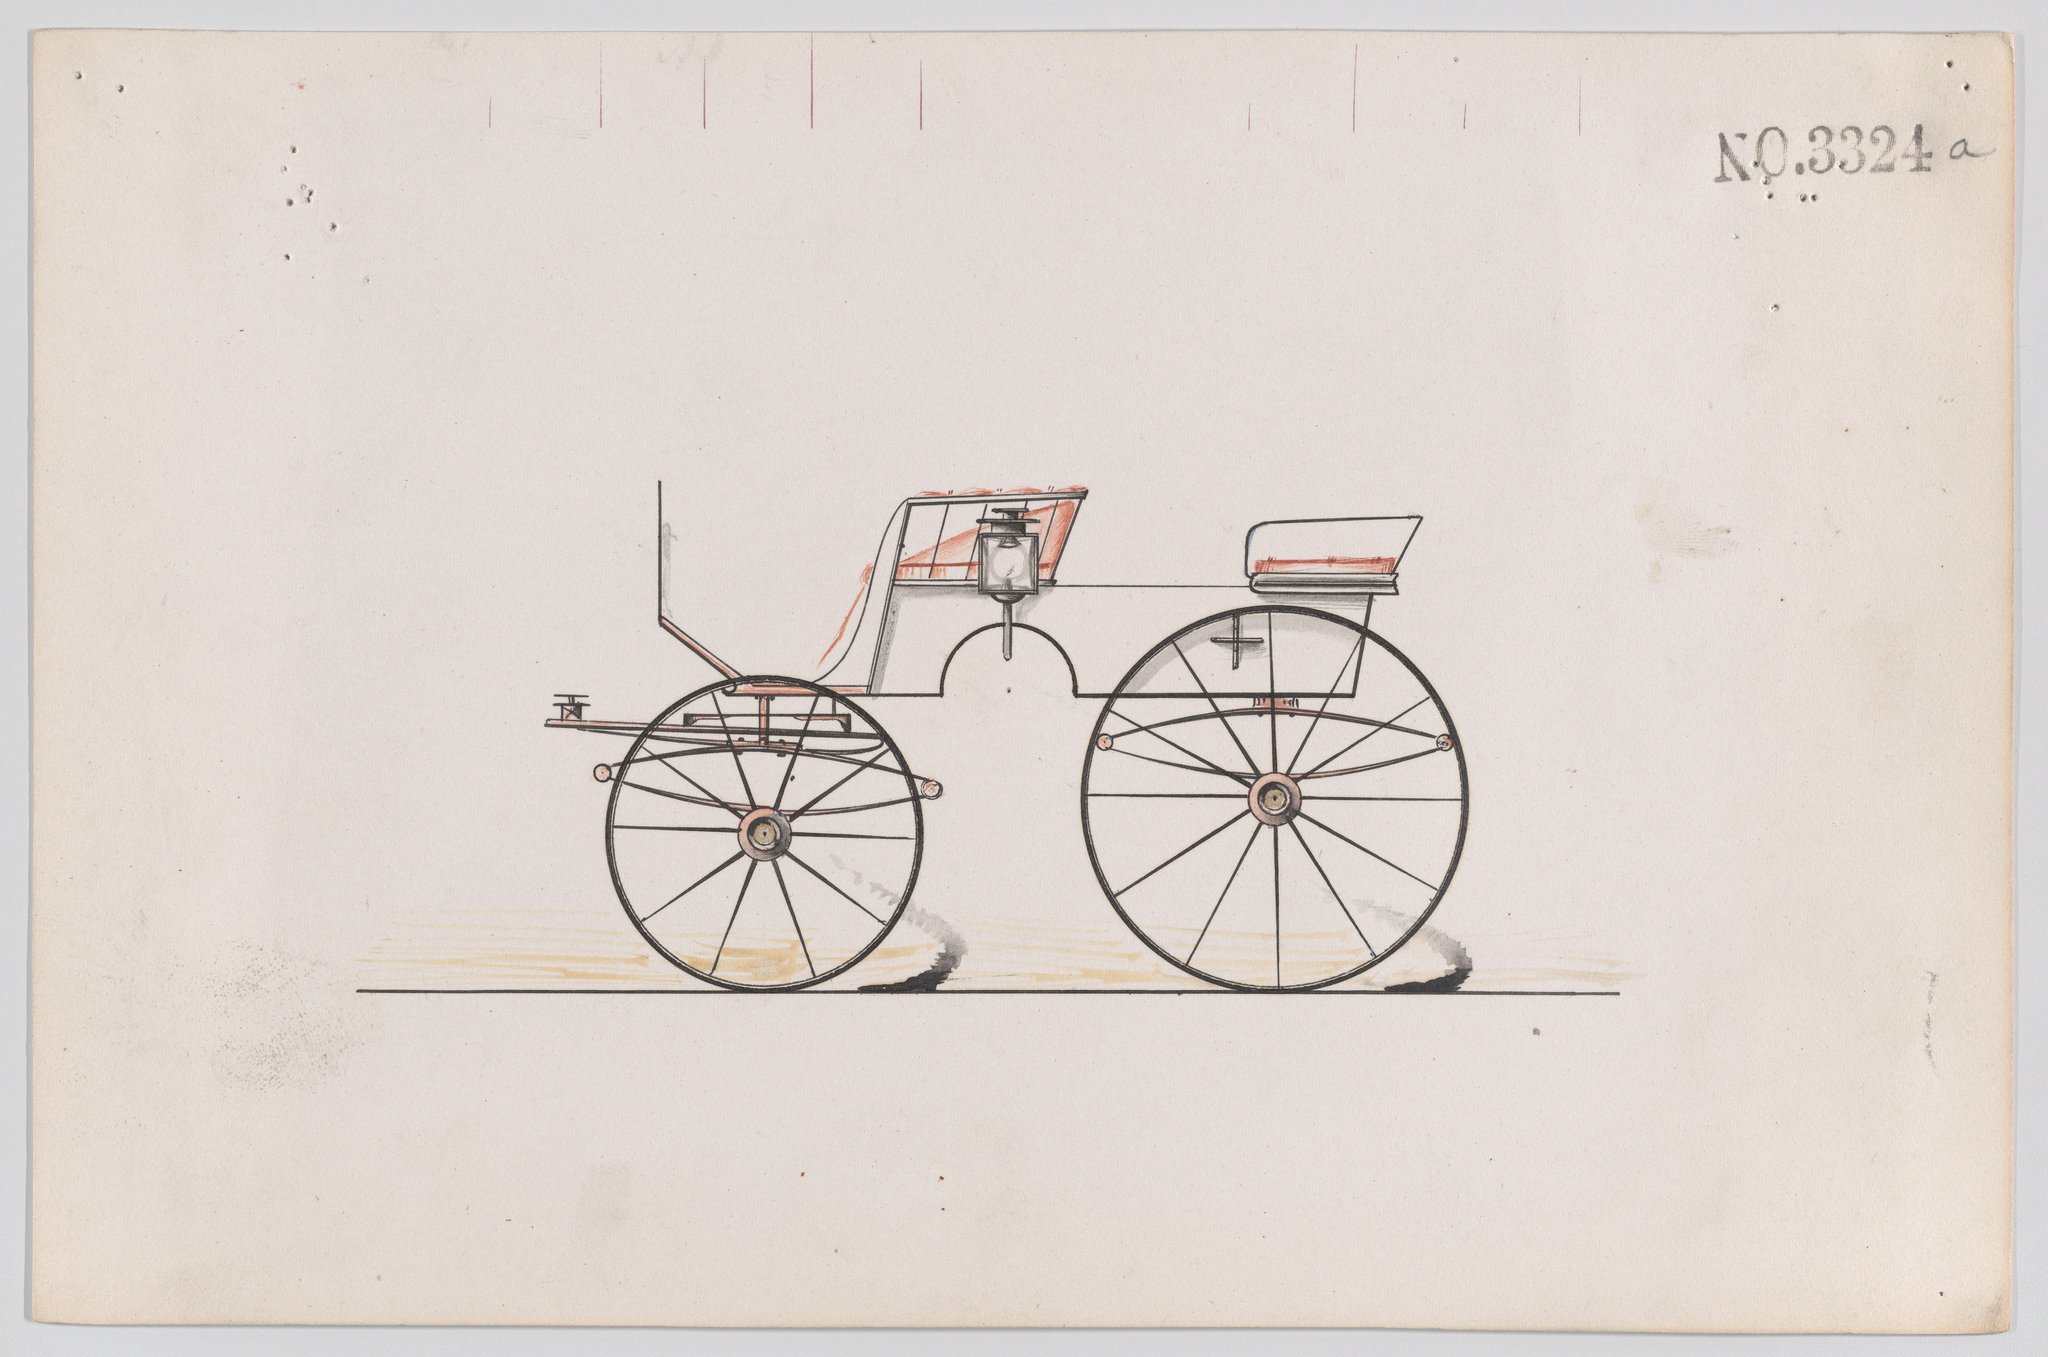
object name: drawing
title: Design for T-Cart, no. 3324a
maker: brewster & co.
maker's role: manufacturer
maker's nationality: american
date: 1877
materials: gouache, ink, watercolor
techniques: pen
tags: carriages